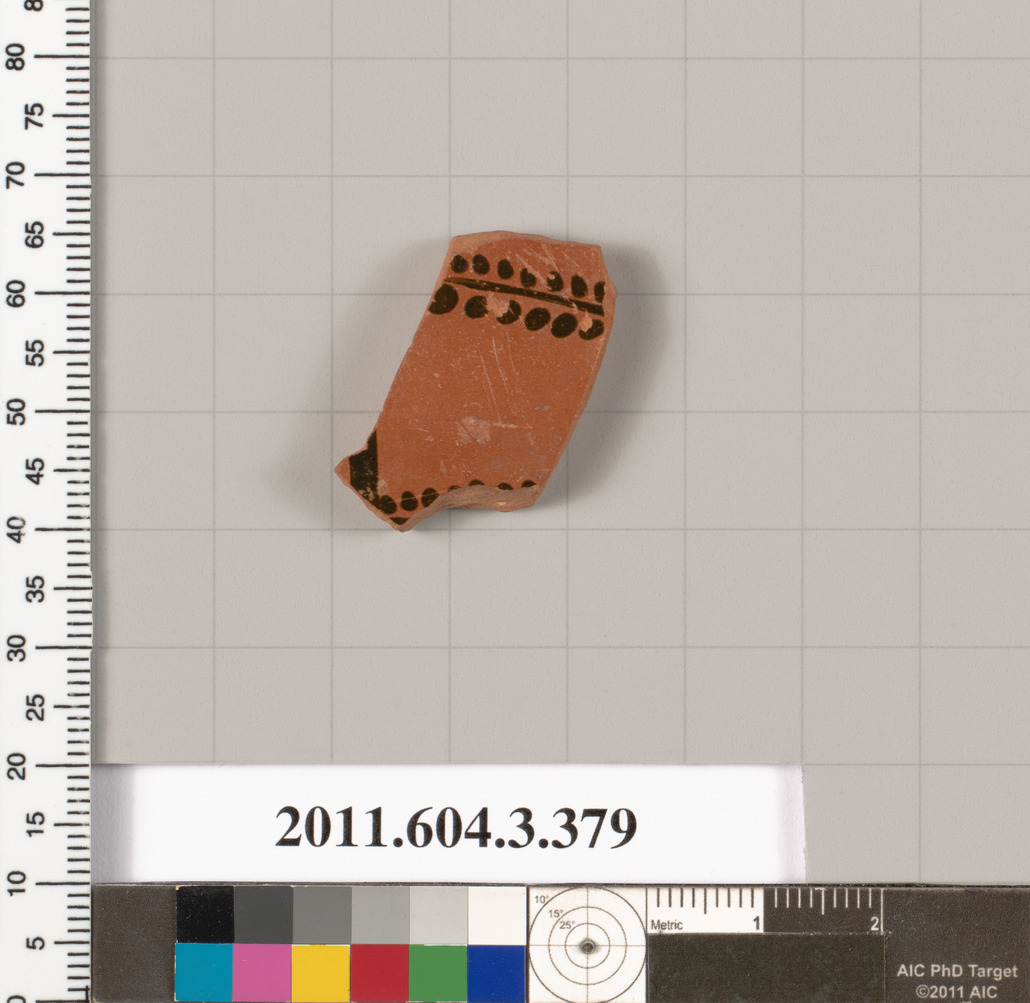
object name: neck amphora fragment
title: Terracotta fragment of a neck-amphora (jar)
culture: greek, attic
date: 525-501 BCE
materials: terracotta